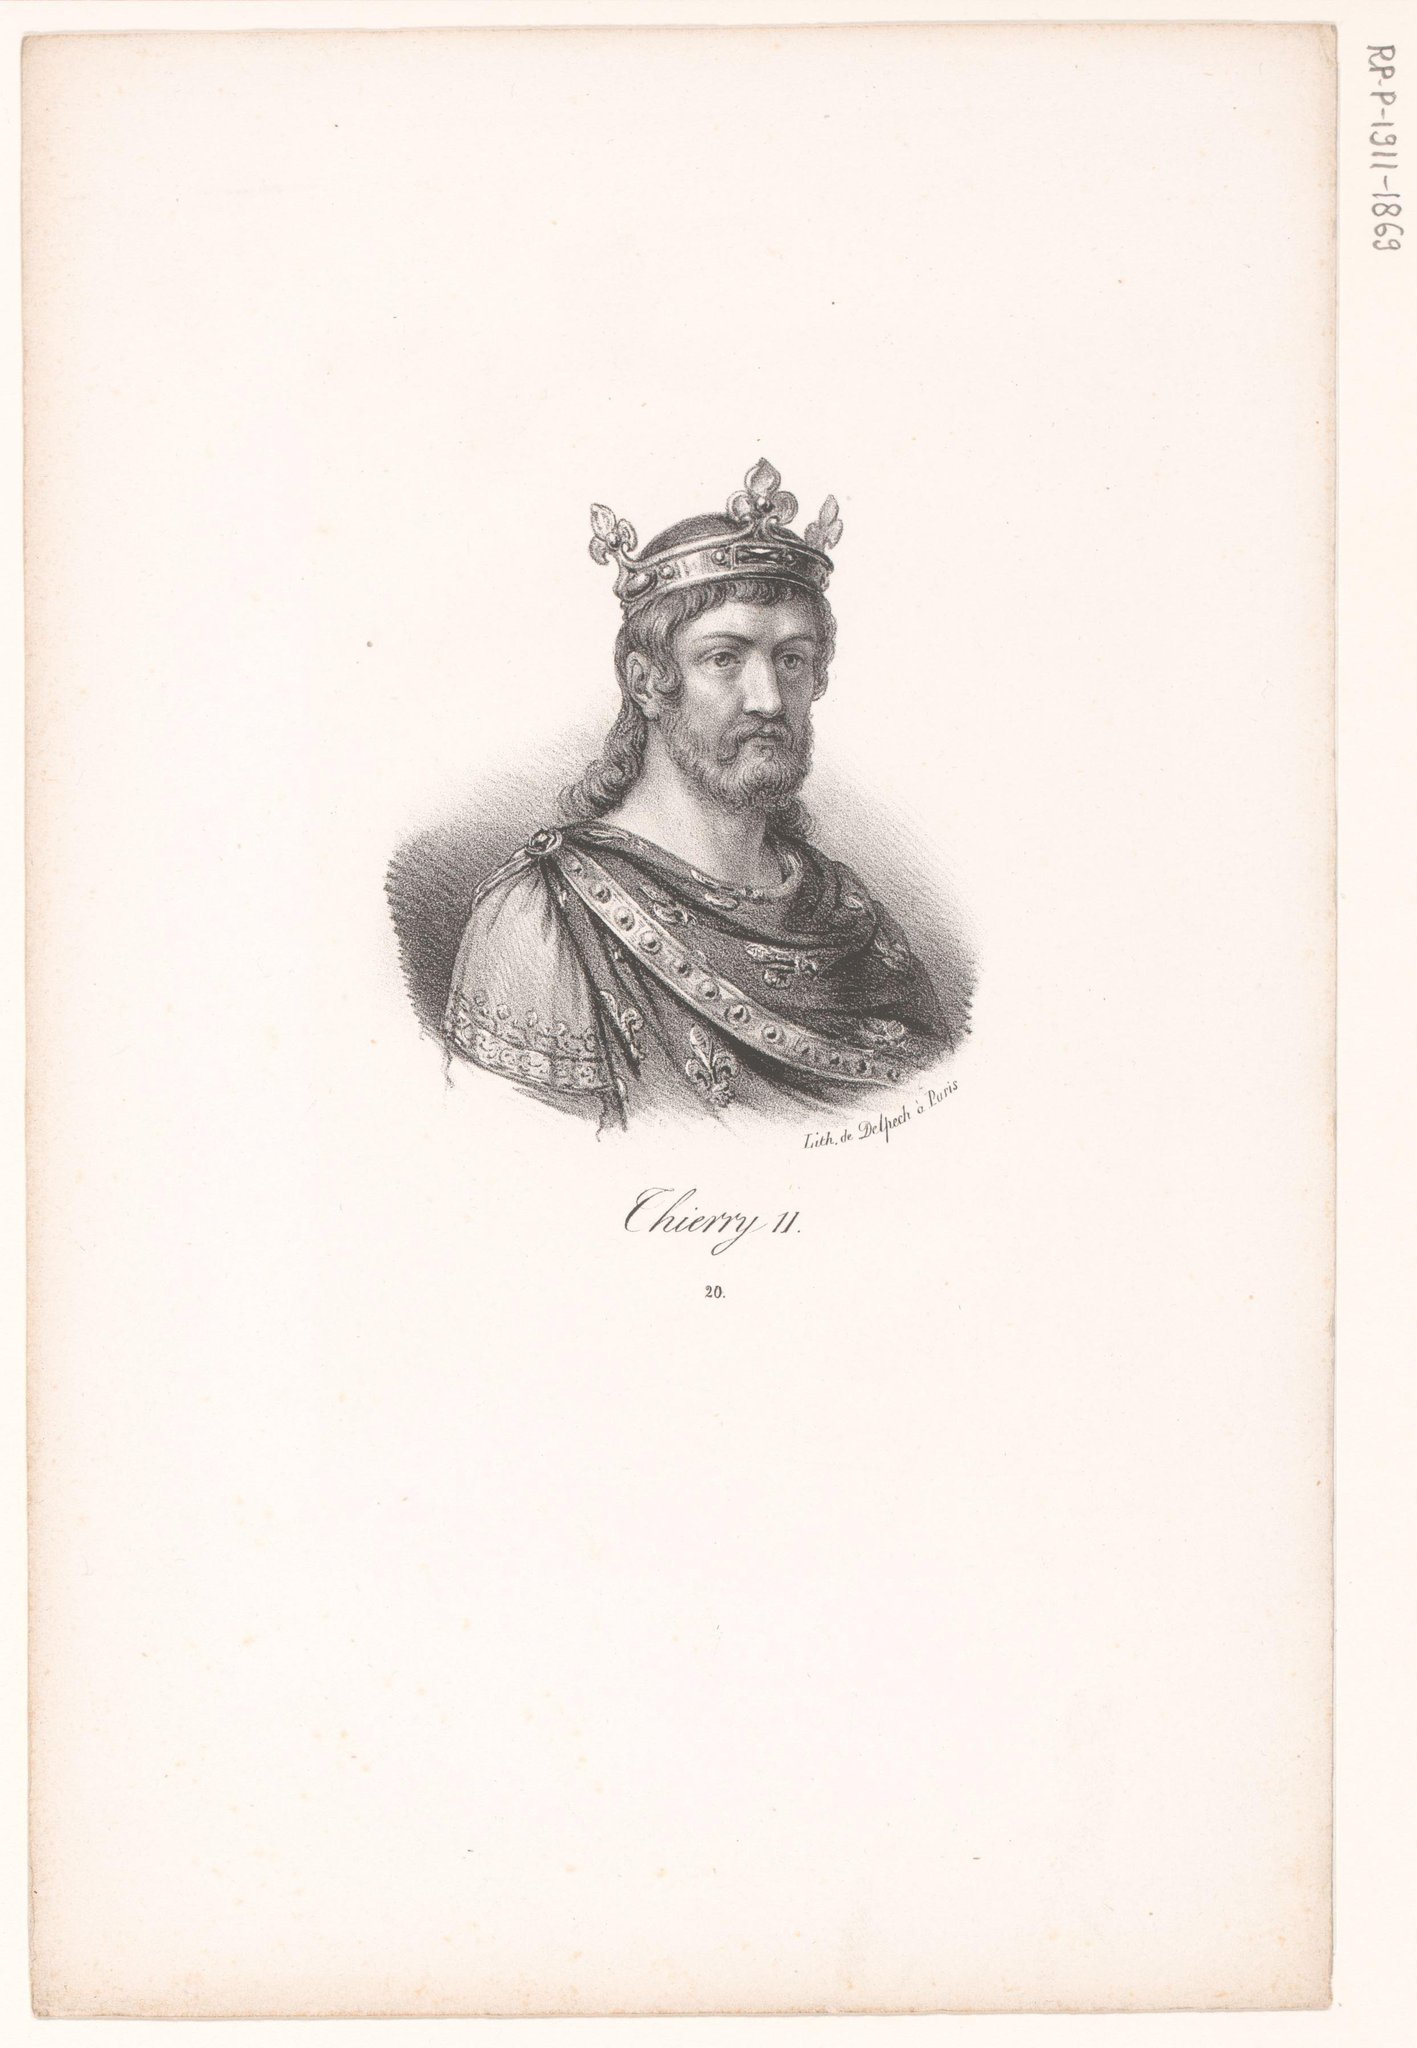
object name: print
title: Portret van Theuderik II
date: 1818-1842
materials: paper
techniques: lithograph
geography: paris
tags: historical persons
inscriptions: collector's mark: Lugt 2228a